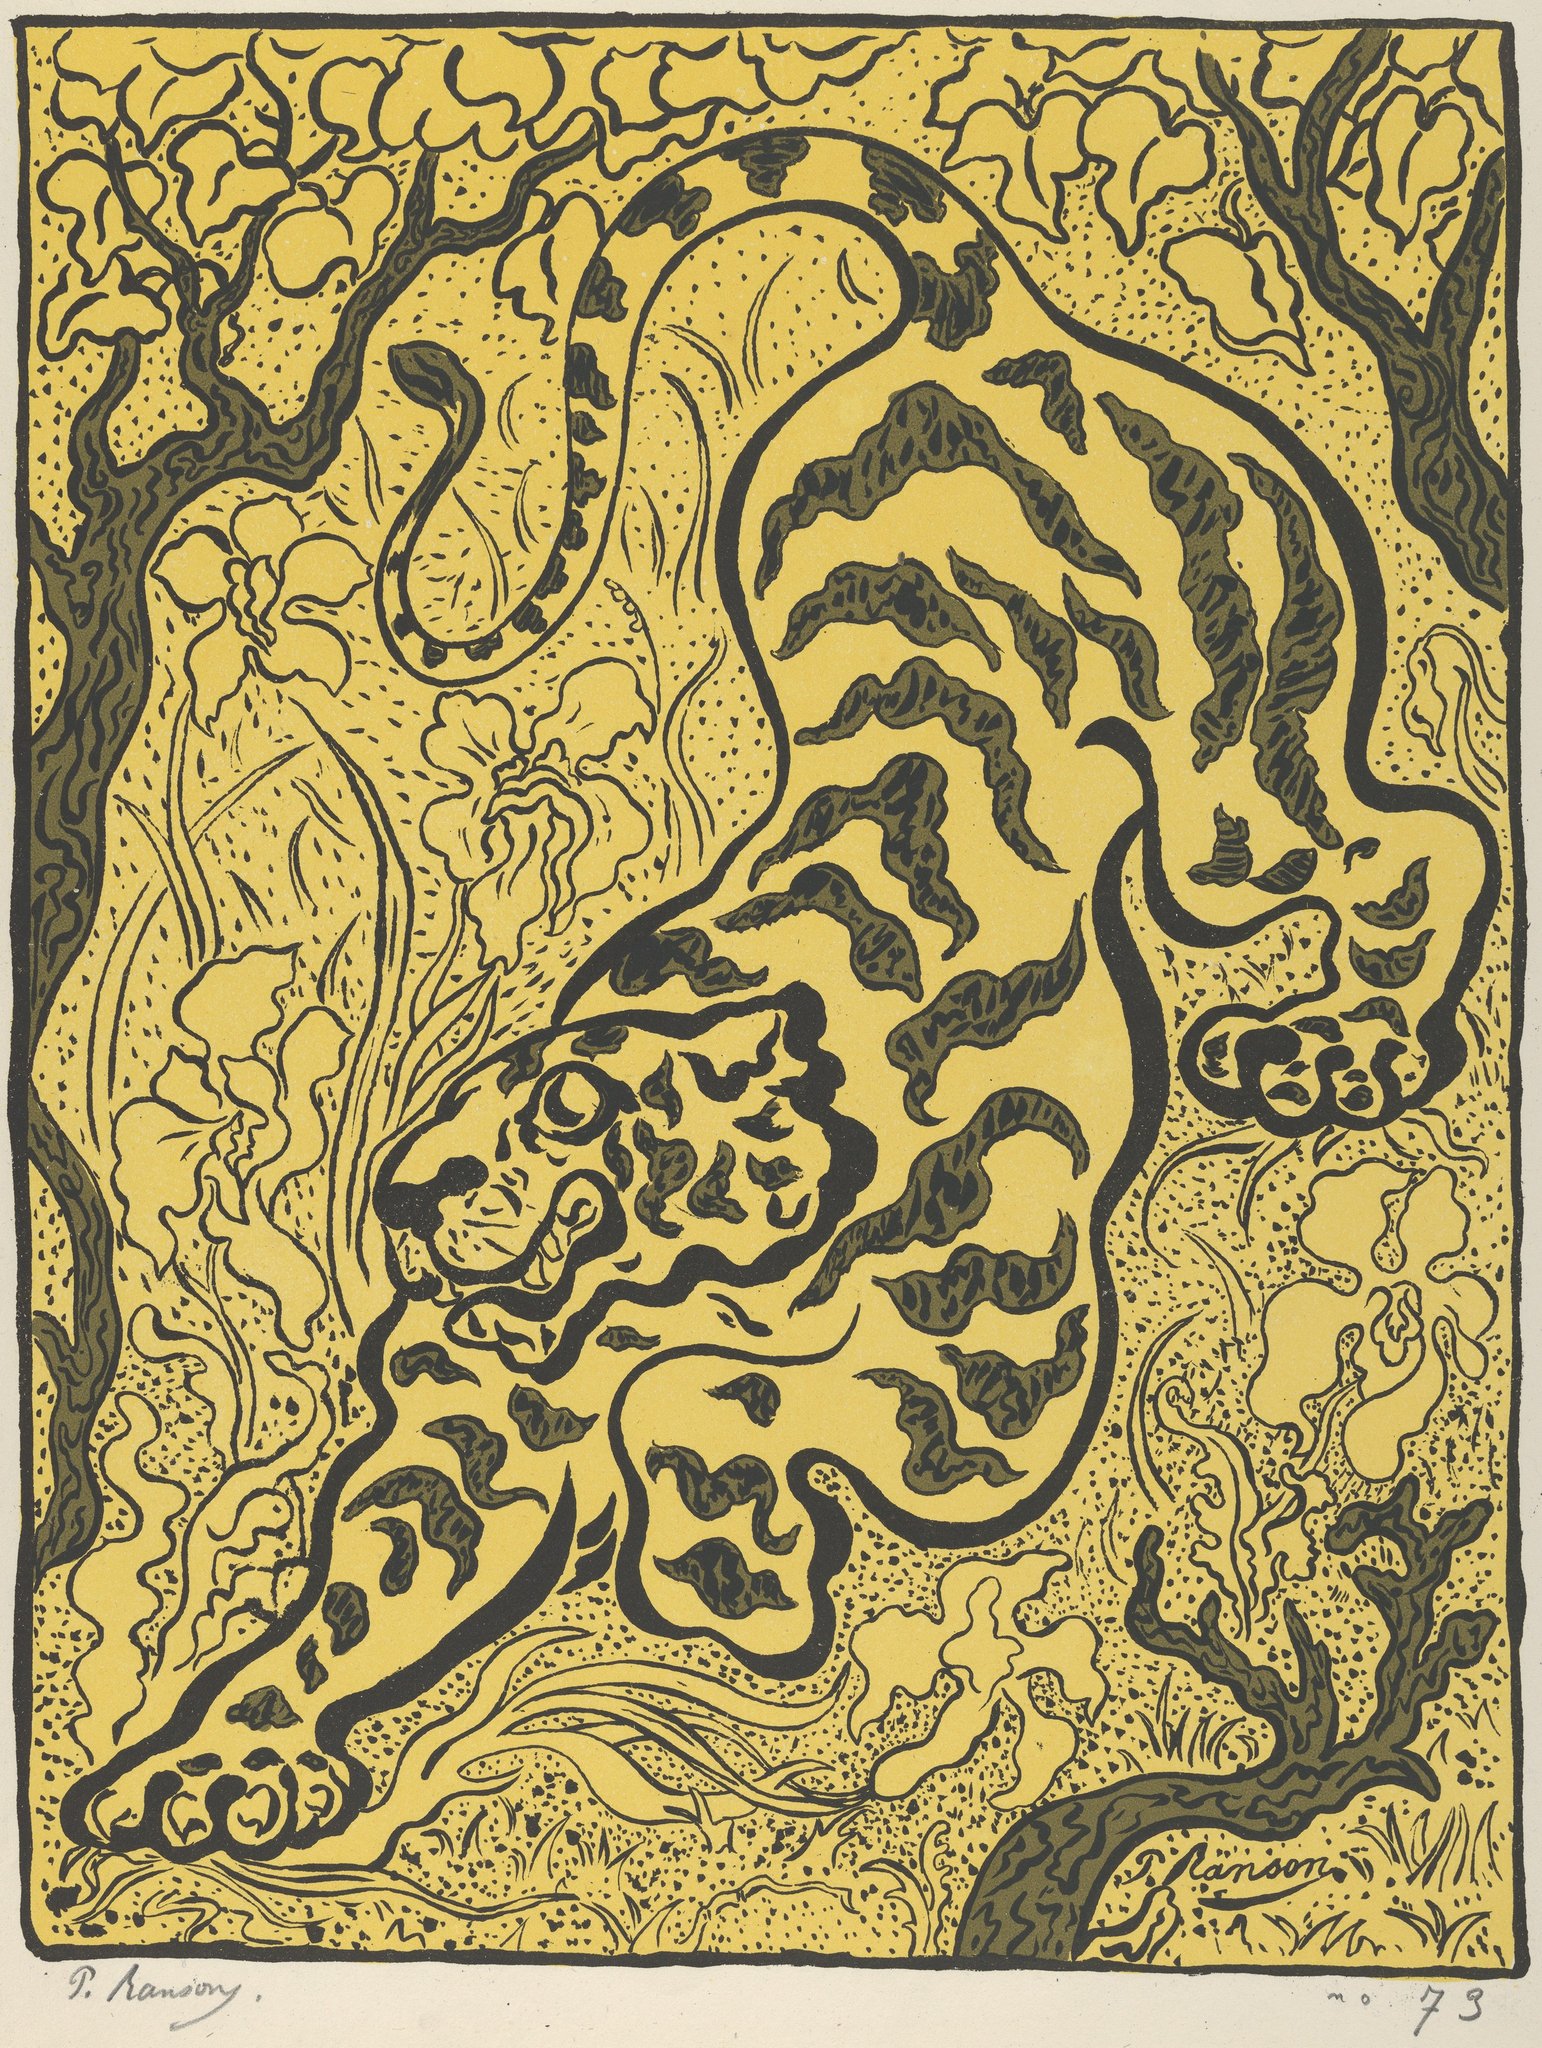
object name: print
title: Tiger in the Jungle, from "L'Estampe Originale"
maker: paul ranson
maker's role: artist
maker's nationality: french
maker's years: 1864-1909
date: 1893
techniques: lithograph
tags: tigers